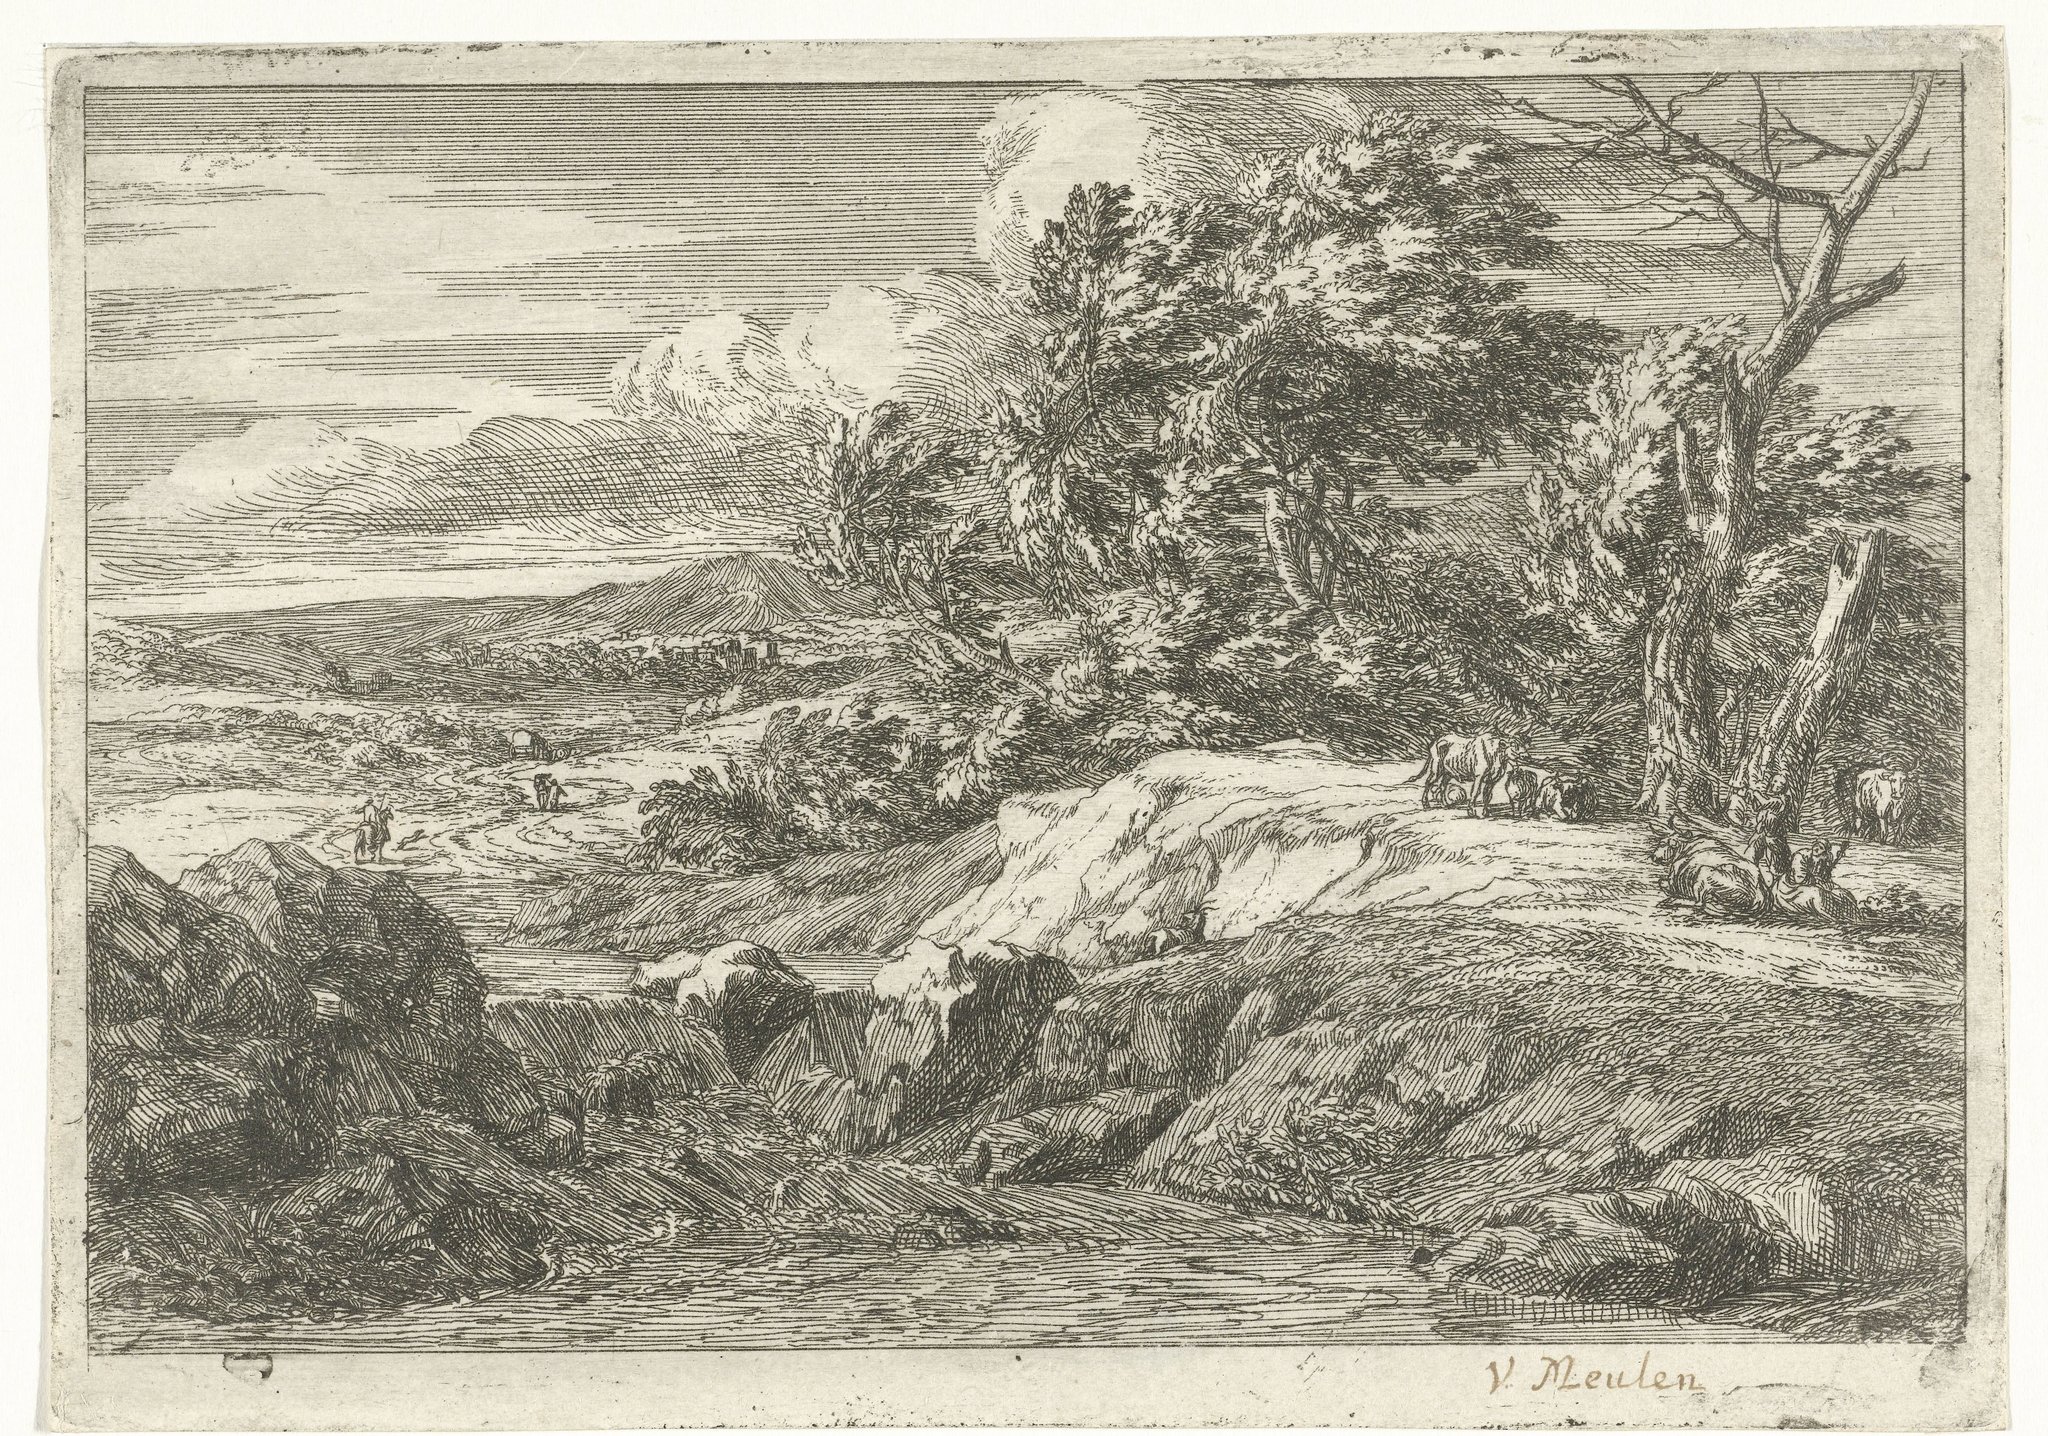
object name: print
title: Landschap met figuren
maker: jan van huchtenburg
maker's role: draughtsman, painter, print maker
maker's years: 1647-1733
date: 1674-1733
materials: paper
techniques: engraving, etching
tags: landscapes (+ landscape with figures, staffage)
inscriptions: collector's mark: Lugt 2228, inscription: ‘V. Meulen’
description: Landschap met rechts twee figuren en koeien voor een bossage. Linksachter een ruiter.